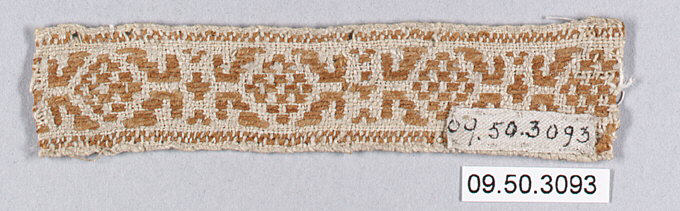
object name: gimp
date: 1701-1900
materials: linen